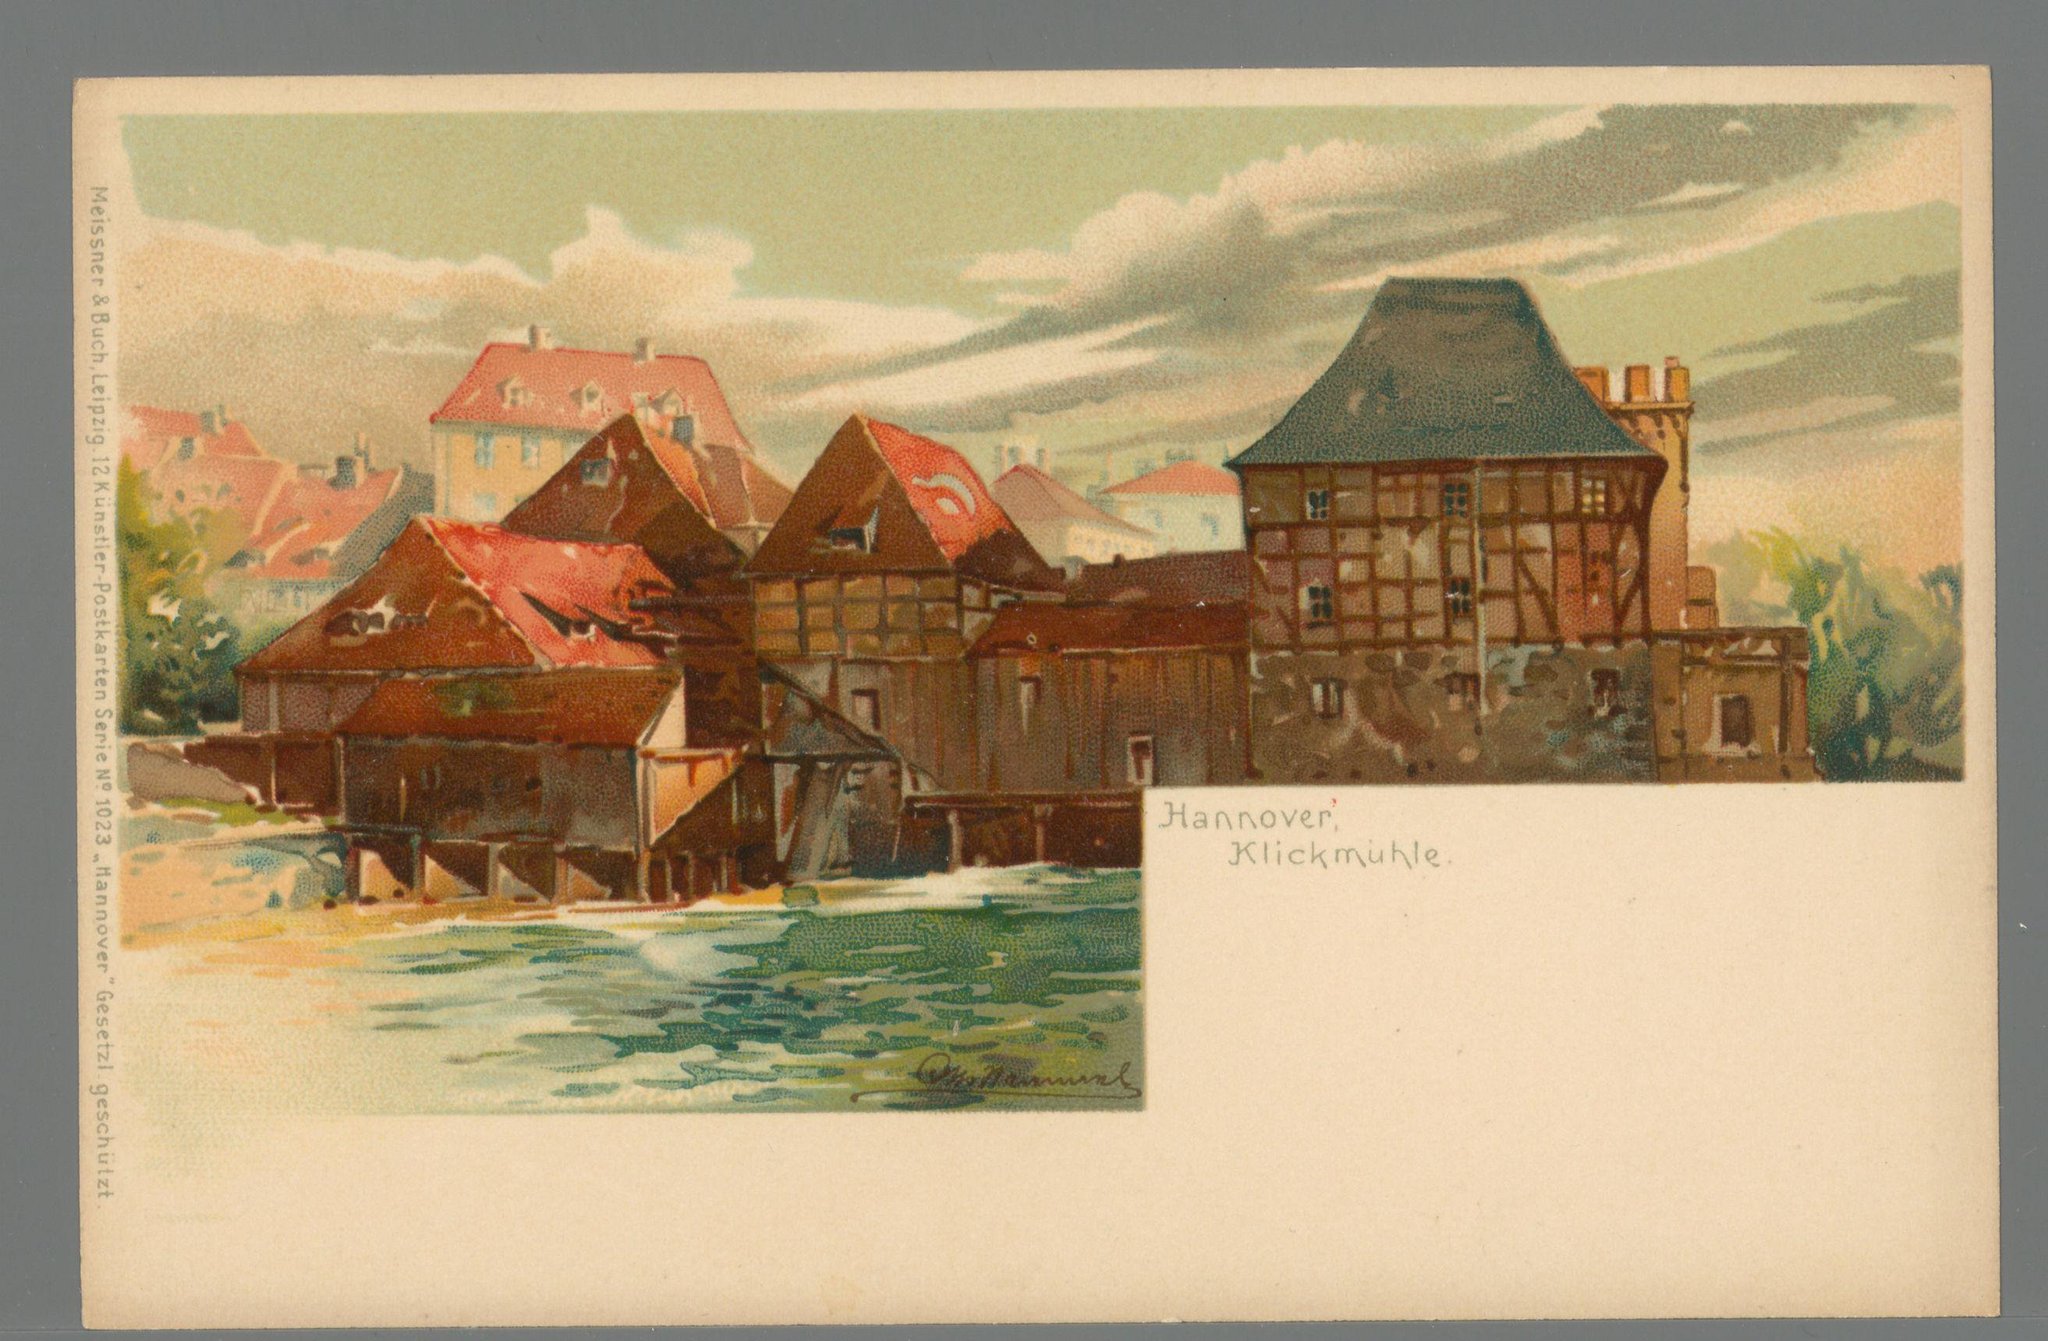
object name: reproduction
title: Hannover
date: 1905-1930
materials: cardboard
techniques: lithograph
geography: leipzig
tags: canals, waters (in city), watermill